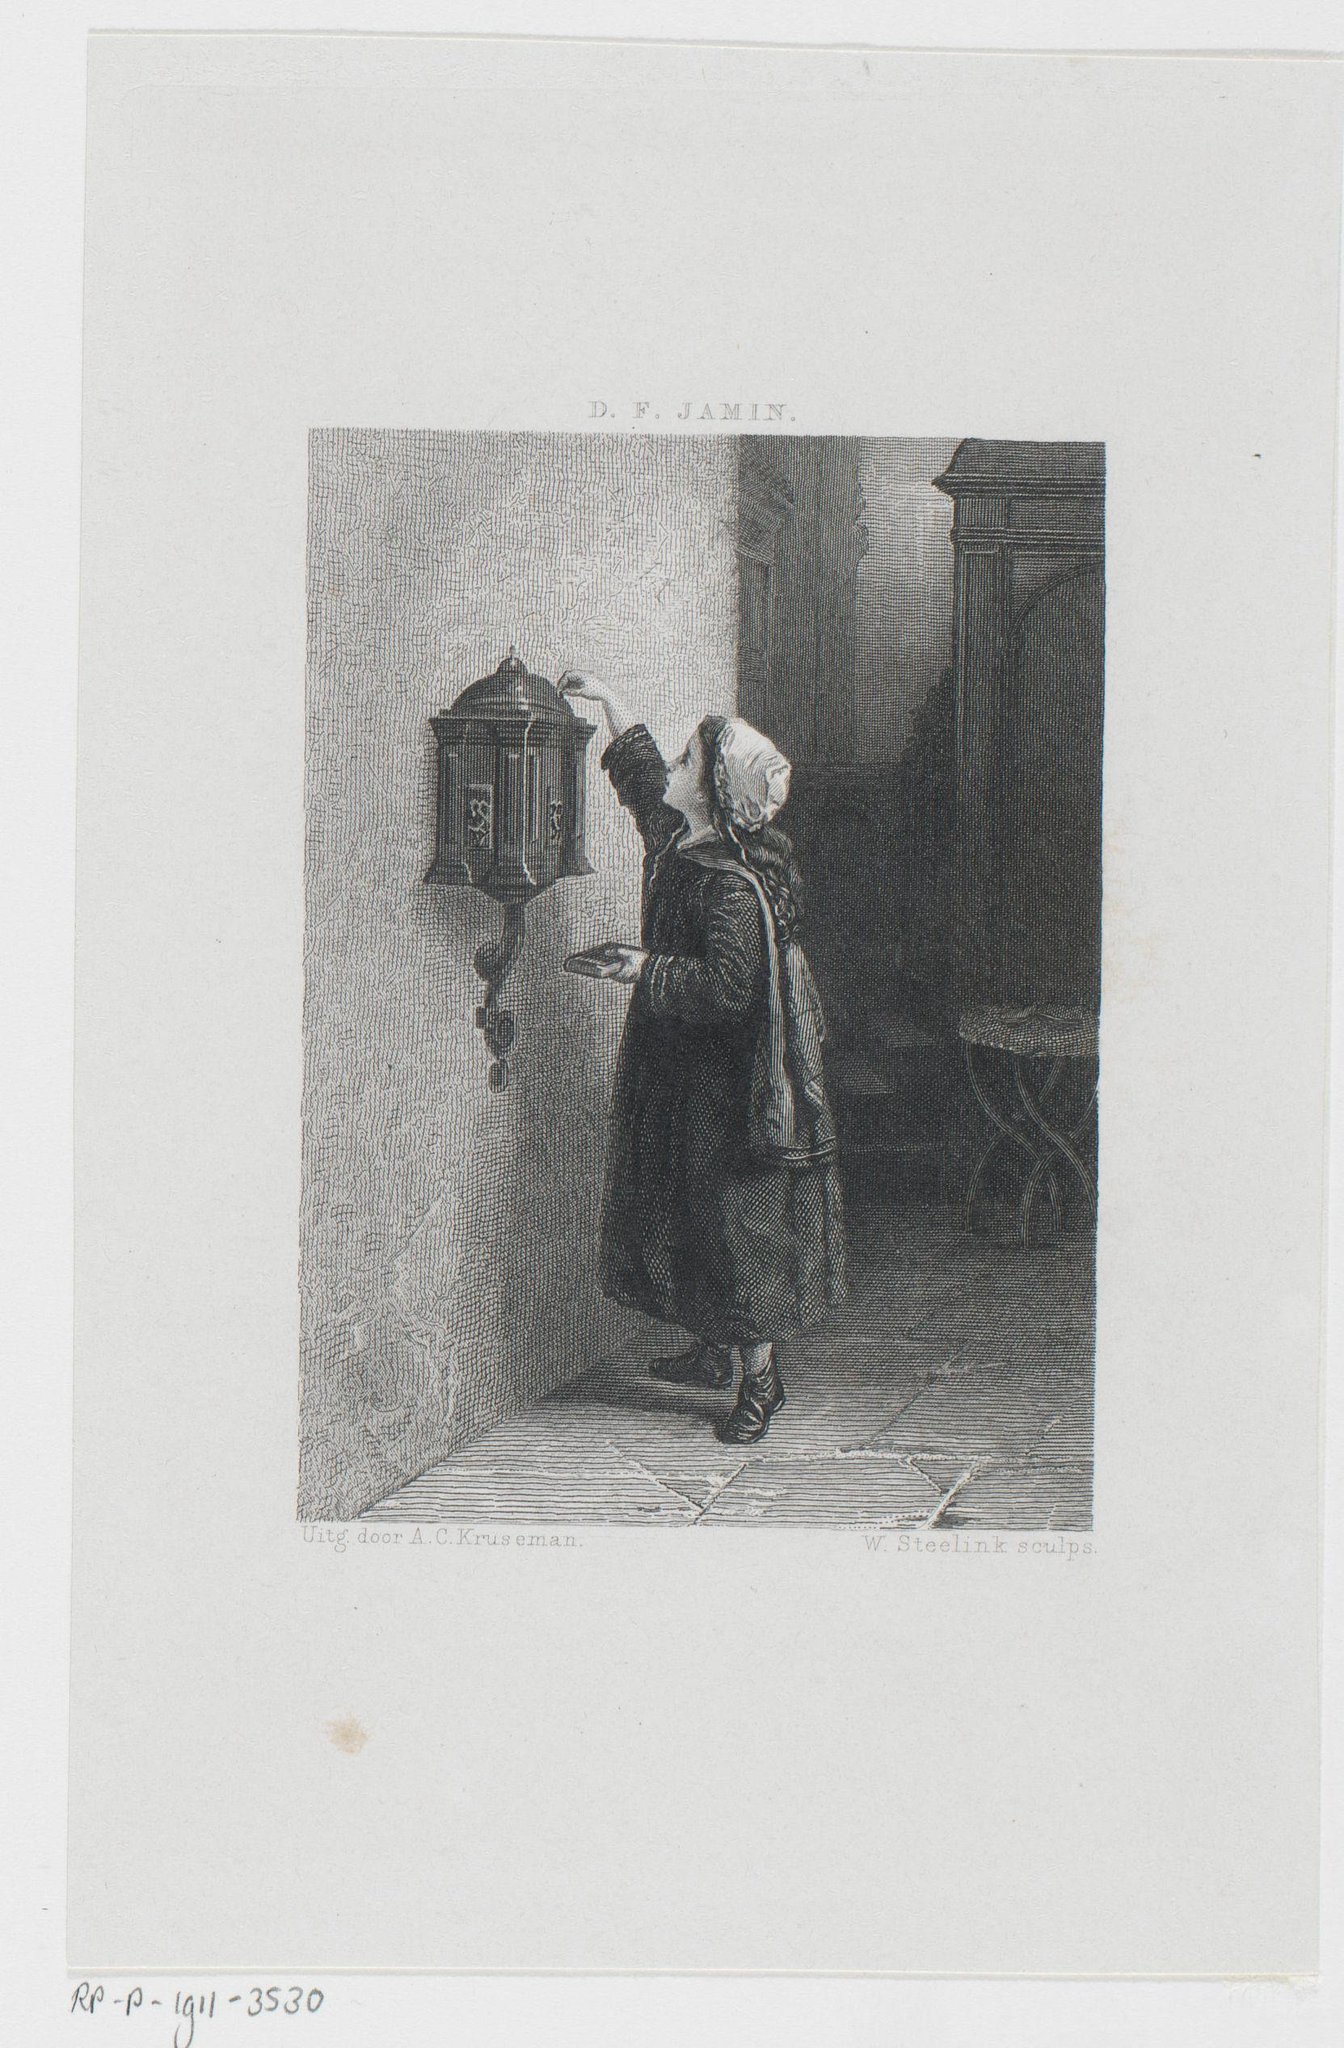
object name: book illustration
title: Meisje doet geld in het offerblok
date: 1861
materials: paper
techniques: etching, engraving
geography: haarlem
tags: money-chest, treasure-chest, money-box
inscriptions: collector's mark: Lugt 2228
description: Illustratie voor: Aurora. Jaarboekjen voor 1861. Haarlem: Arie Cornelis Kruseman, 1861.